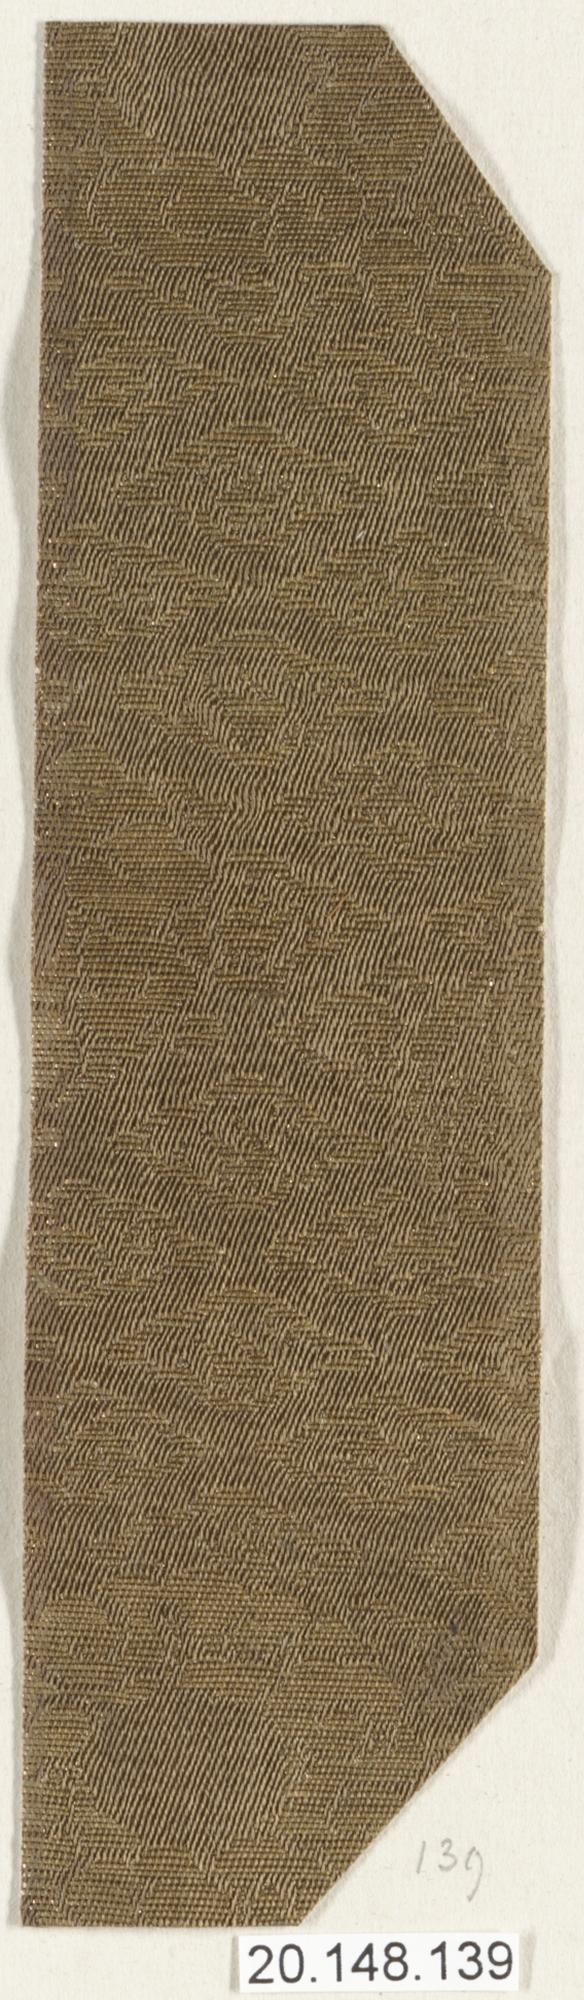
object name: piece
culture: japanese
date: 1601-1700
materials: silk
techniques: compound weave